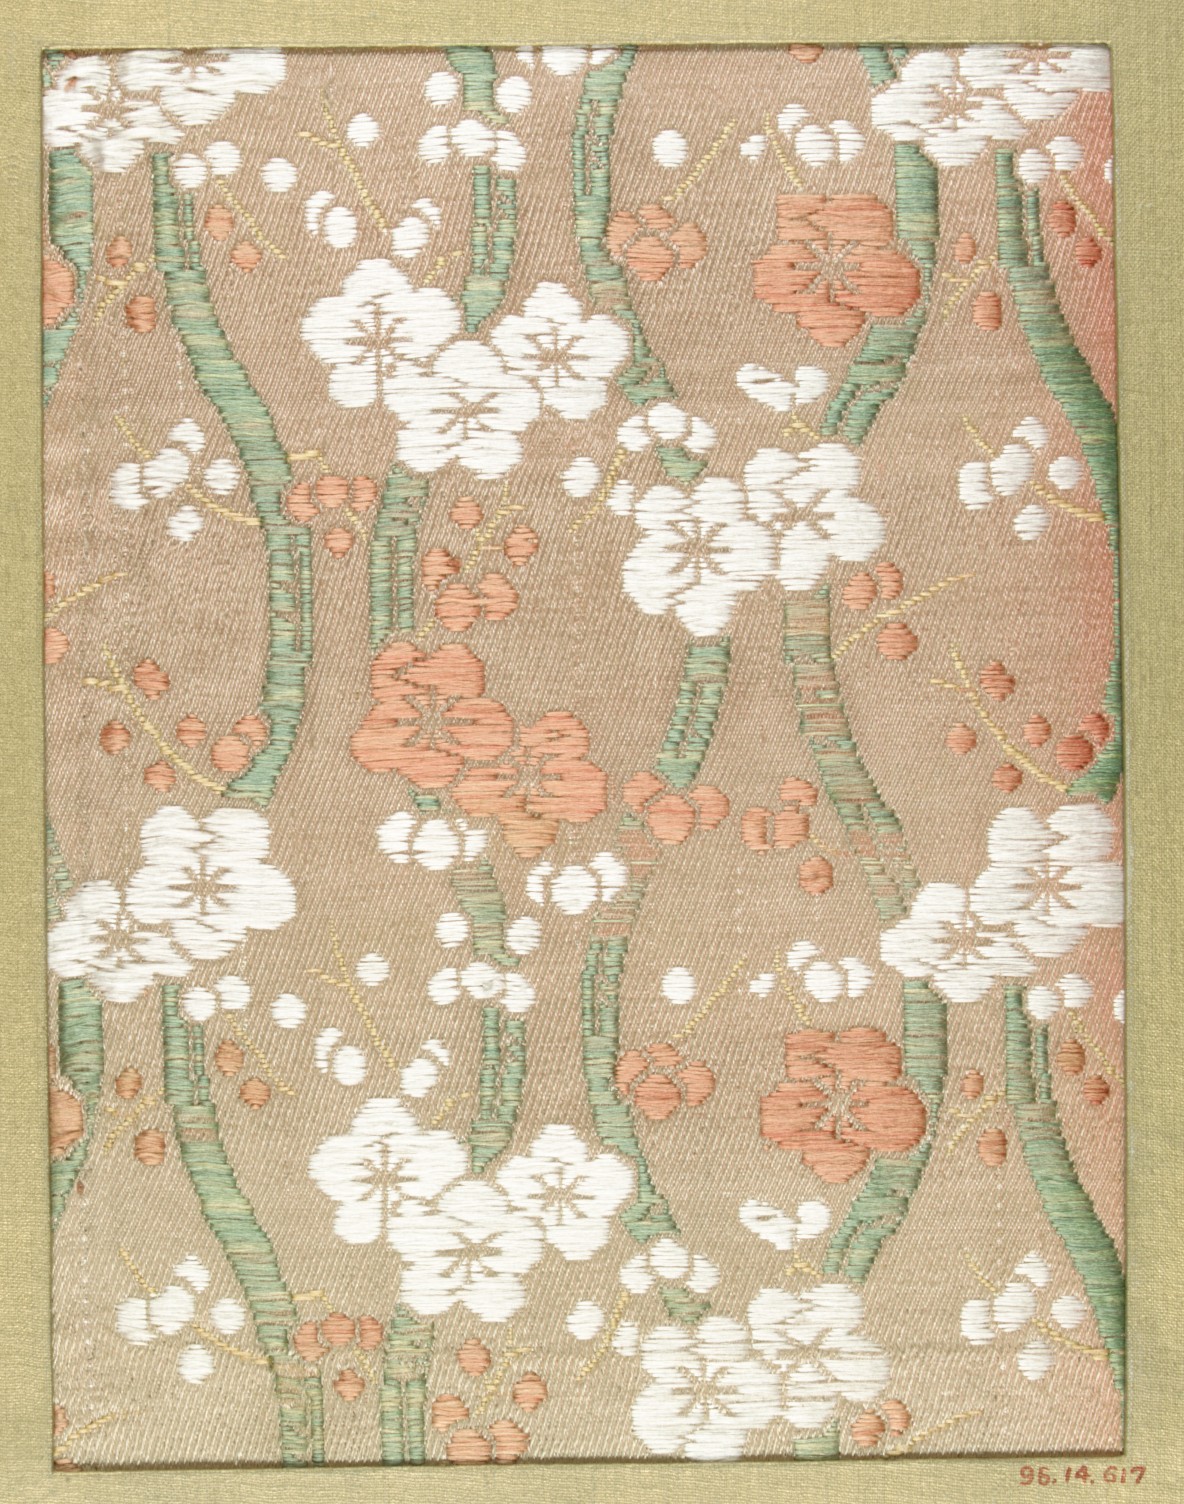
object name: piece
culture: japanese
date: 1701-1900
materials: silk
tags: flowers